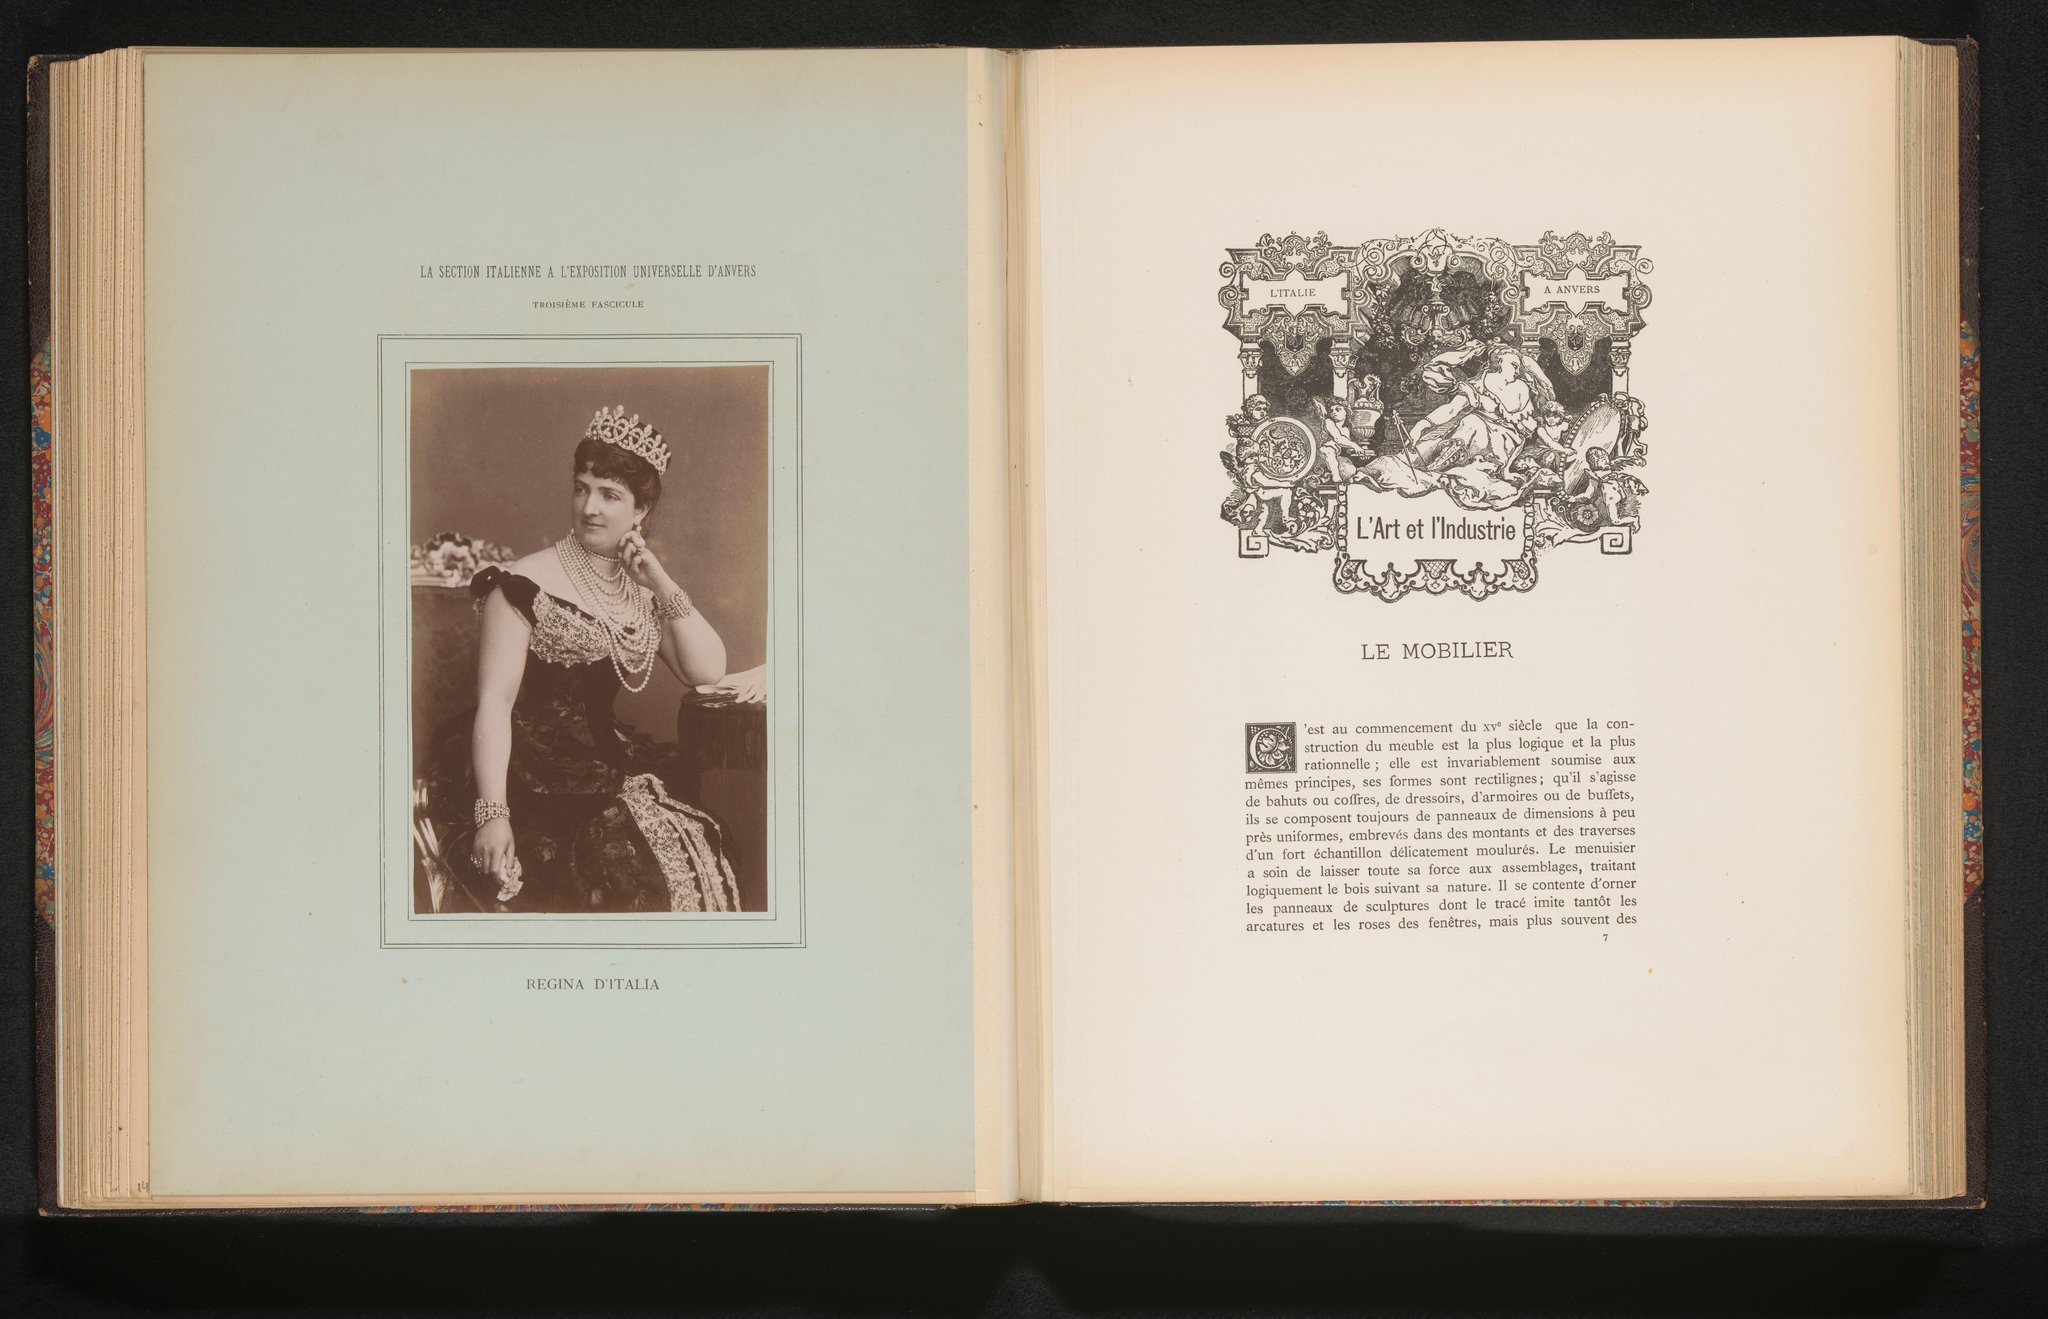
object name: page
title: Portret van Margaretha van Savoye, koningin van Italië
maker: Anonymous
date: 1880-1885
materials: photographic support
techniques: albumen print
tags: historical persons - bb - woman, queen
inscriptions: inscription: ‘La section Italienne a l'exposition universelle d'Anvers/ premies fascicule’